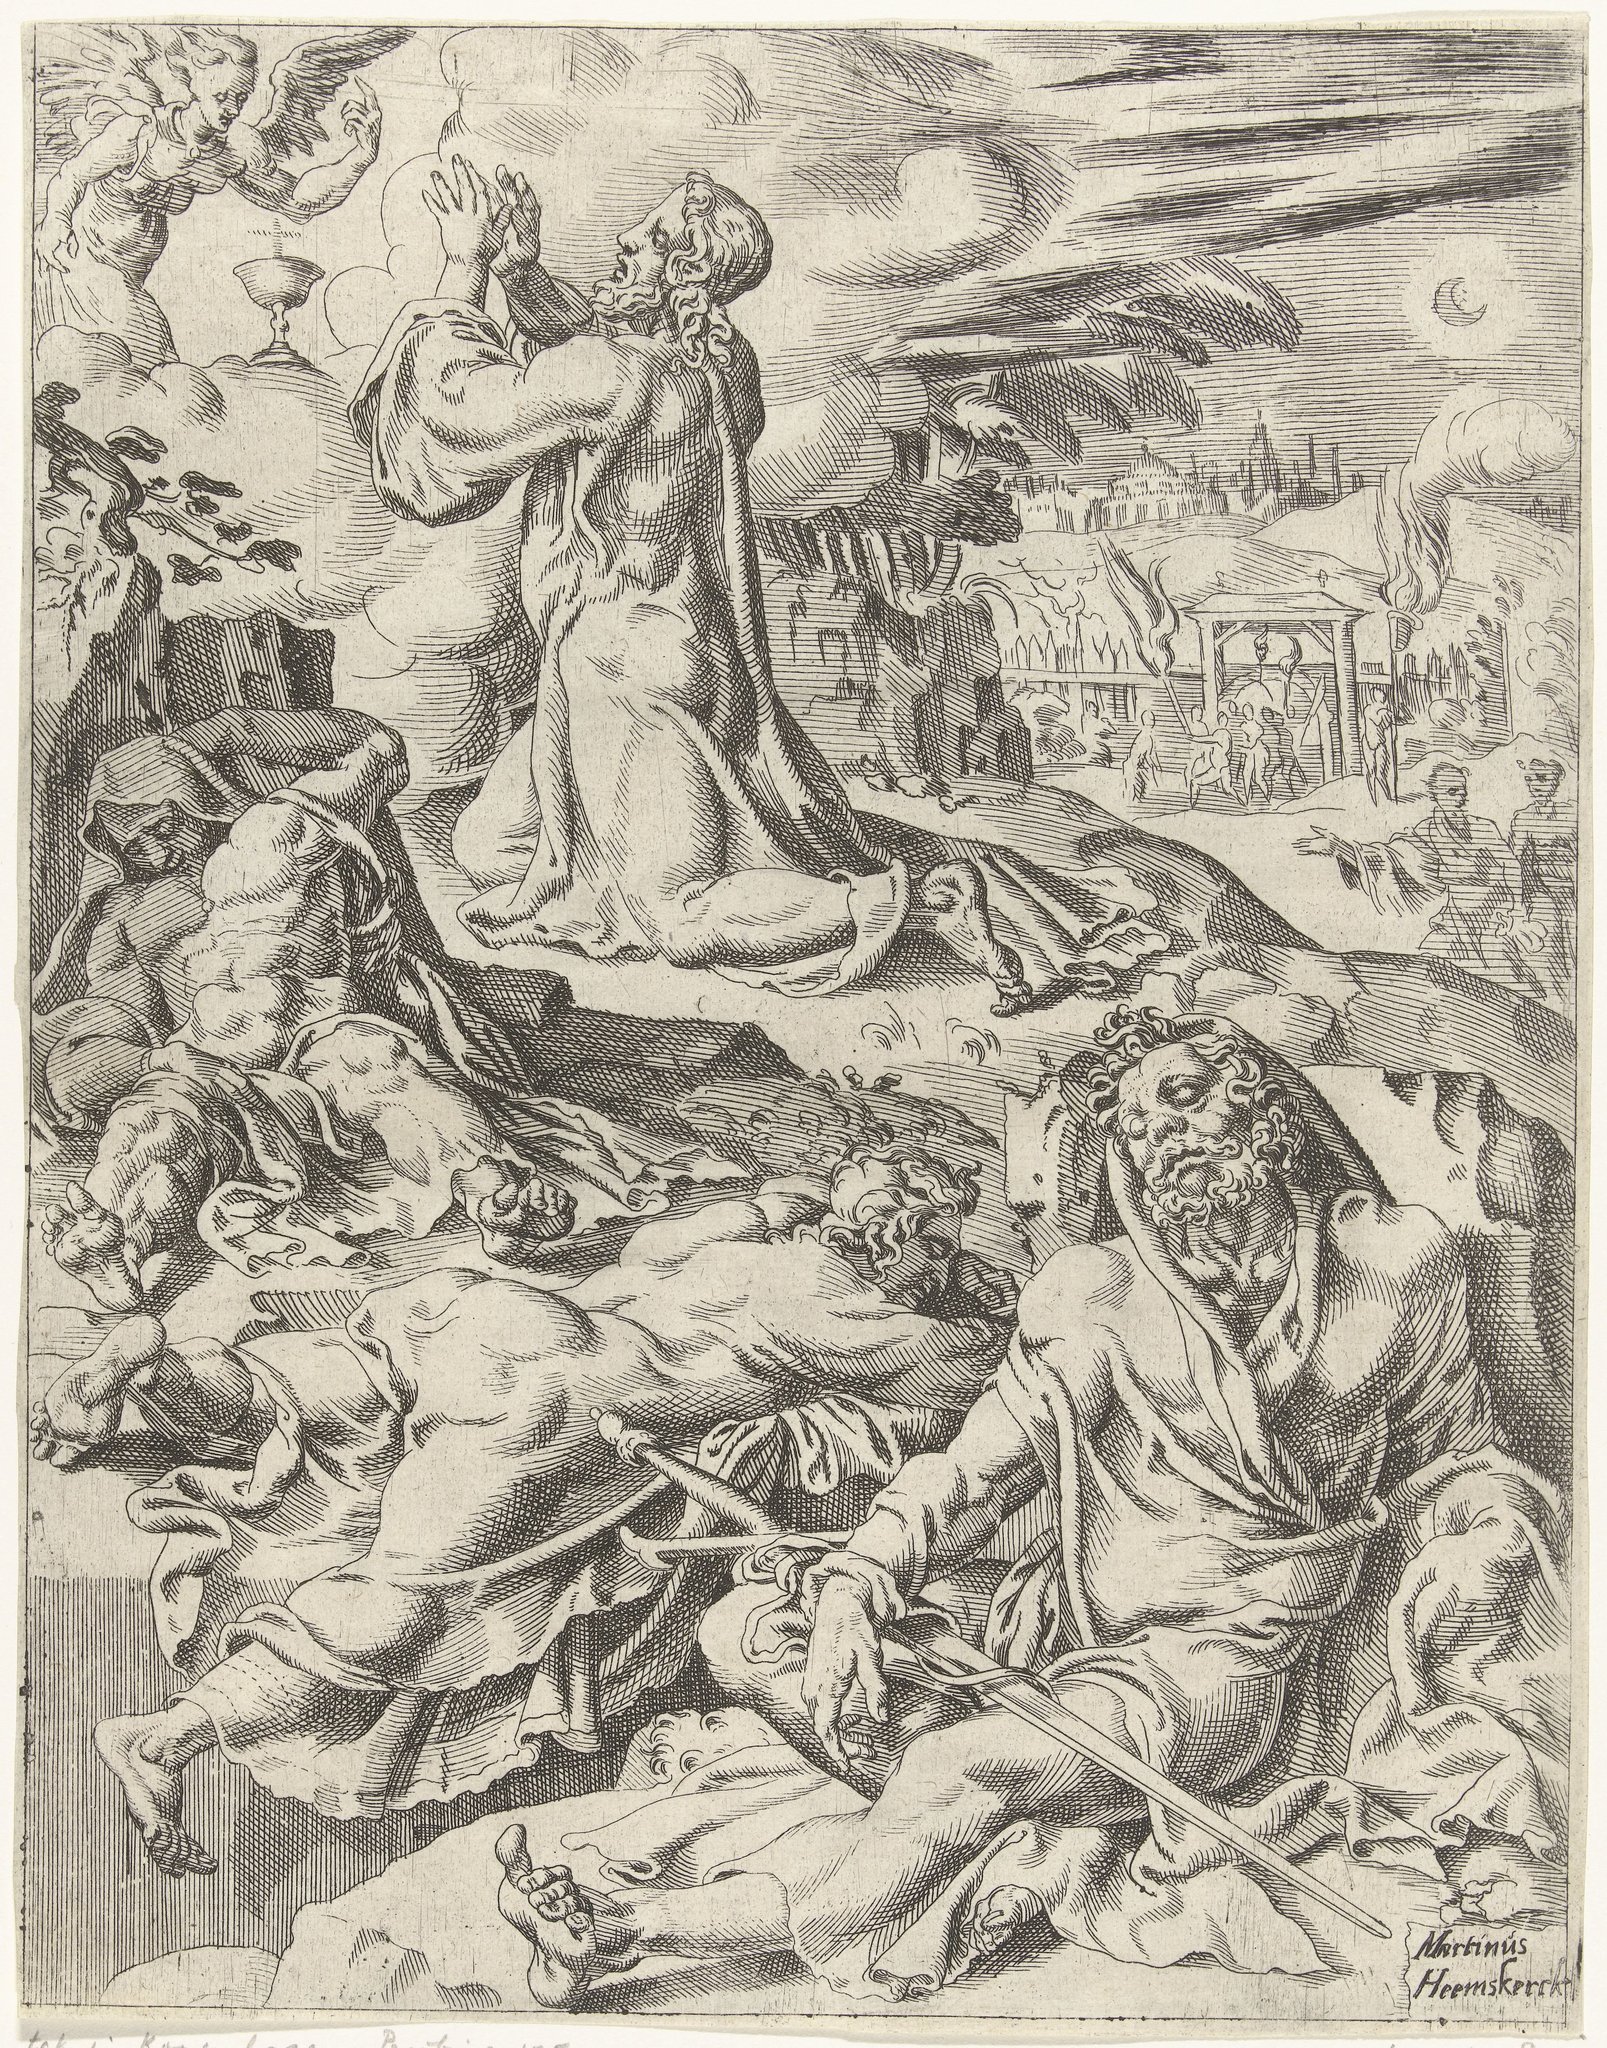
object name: print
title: Val en de verlossing van de mensheid door het leven en passie van Christus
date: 1548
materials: paper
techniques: etching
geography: haarlem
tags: agony of christ; three (or eleven) apostles sleeping, agony of christ: to comfort him one or more angels appear to christ with chalice and/or cross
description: Christus bidt tot God in de hof van olijven. Zijn drie leerlingen slapen ondertussen. In de wolken verschijnt een engel om hem te troosten. In de achtergrond wijst Judas de soldaten de plek waar Christus bidt. De prent is deel van een dertigdelige serie met prenten over de zondeval en Christus' passie.